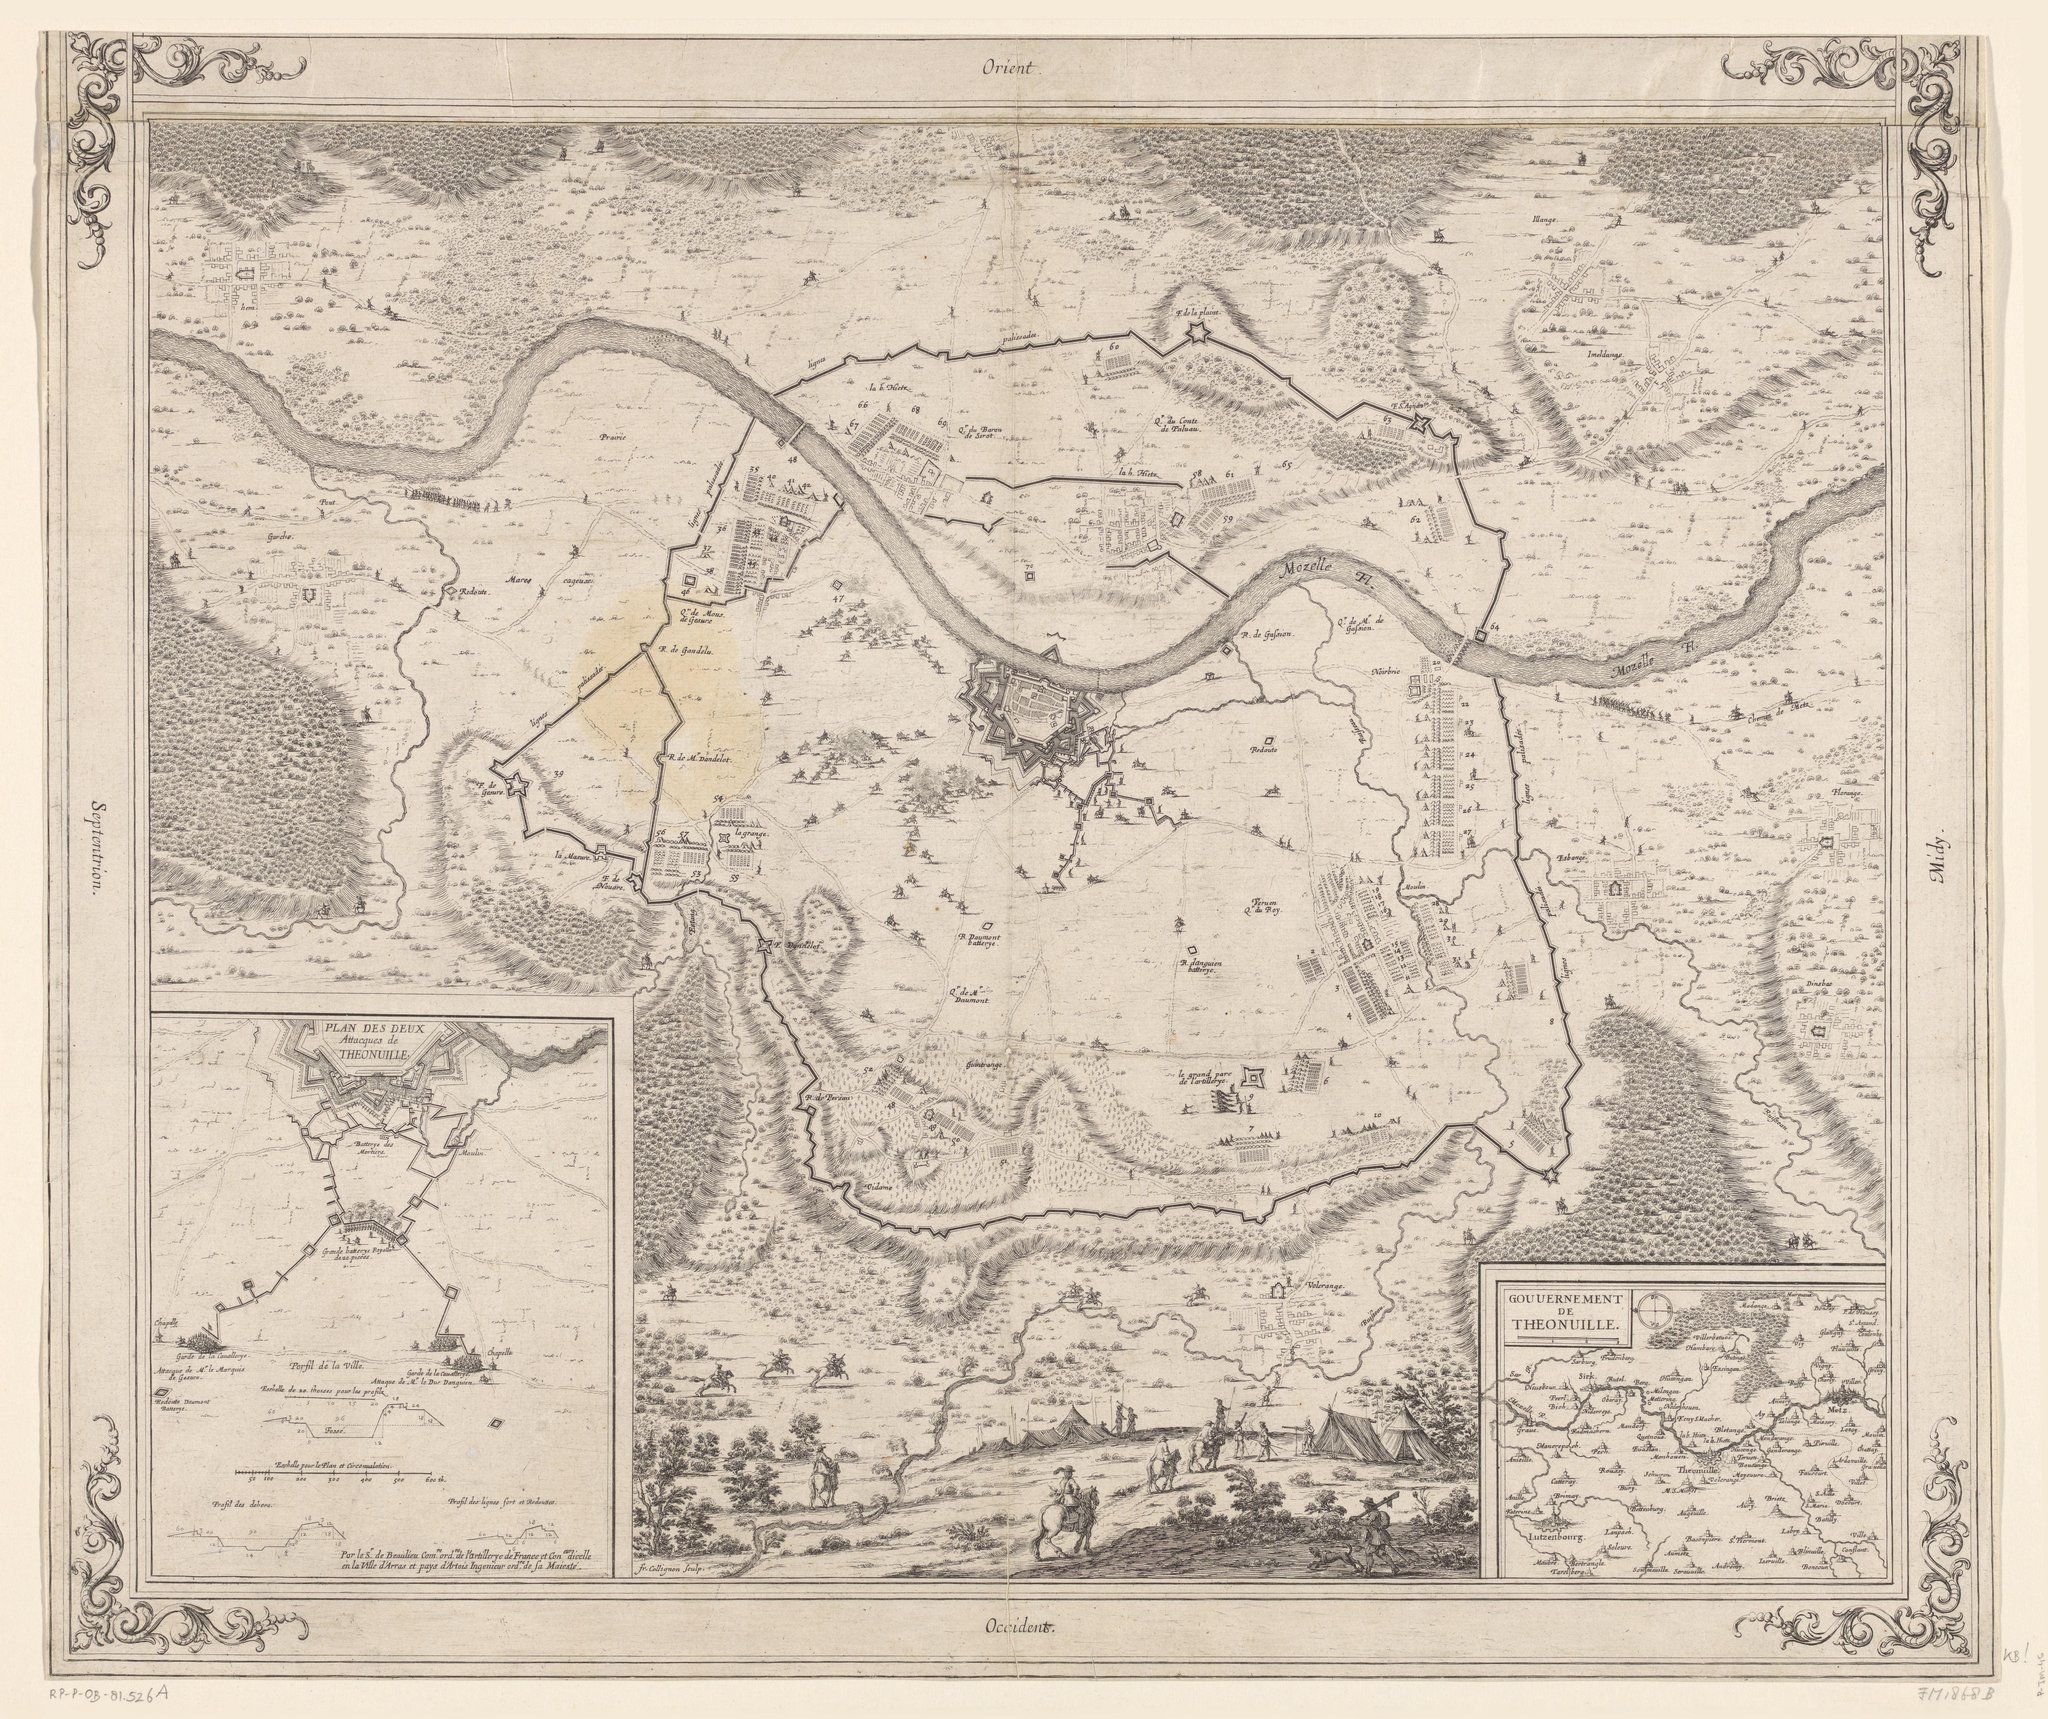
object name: map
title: Plan de la ville de Theonville au Duché de Luxembourg. Assiegee par l'armee de sa majesté tres-chrestienne Louis XIIII roy de France et de Navarre. Commandee par monseigneur le Duc d'Anguien, Pair de France, General de l'Armée de sa Majesté en Picardie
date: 1644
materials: paper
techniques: etching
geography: france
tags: lodewijk xiv (koning van frankrijk), paris, lodewijk ii de bourbon-condé (hertog van enghien), maps of separate countries or regions, siege, position war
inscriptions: collector's mark: Lugt 240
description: Kaart van de belegering van Thionville door het Franse leger onder bevel van Lodewijk II van Bourbon-Condé, de hertog van Enghien, 18 juni - 10 augustus 1643. Hoofdvoorstelling in een ongemonteerd ensemble bestaande uit de kaart van het beleg en vier tekstbladen. Onderaan twee inzetten met kaarten van een detail van de belegeringswerken onder de stad en van het groter gebied. Onderaan ook een gezicht in het legerkamp met tenten en soldaten. In de vier hoeken ornamenten.